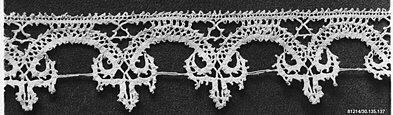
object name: edging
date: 1501-1600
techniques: lace